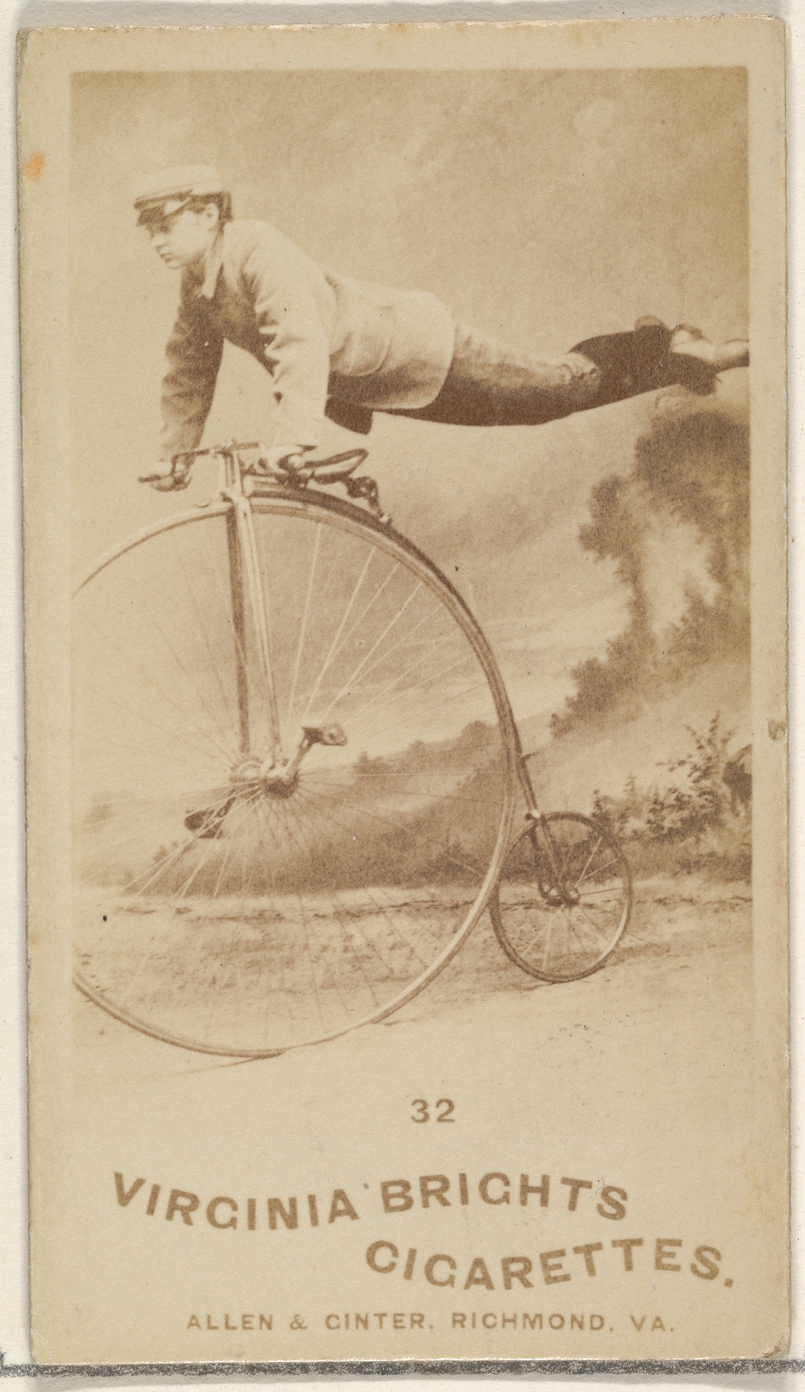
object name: photograph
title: Card 32, from the Girl Cyclists series (N49) for Virginia Brights Cigarettes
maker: allen & ginter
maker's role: publisher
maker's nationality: american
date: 1887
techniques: albumen silver print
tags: women,bicycles